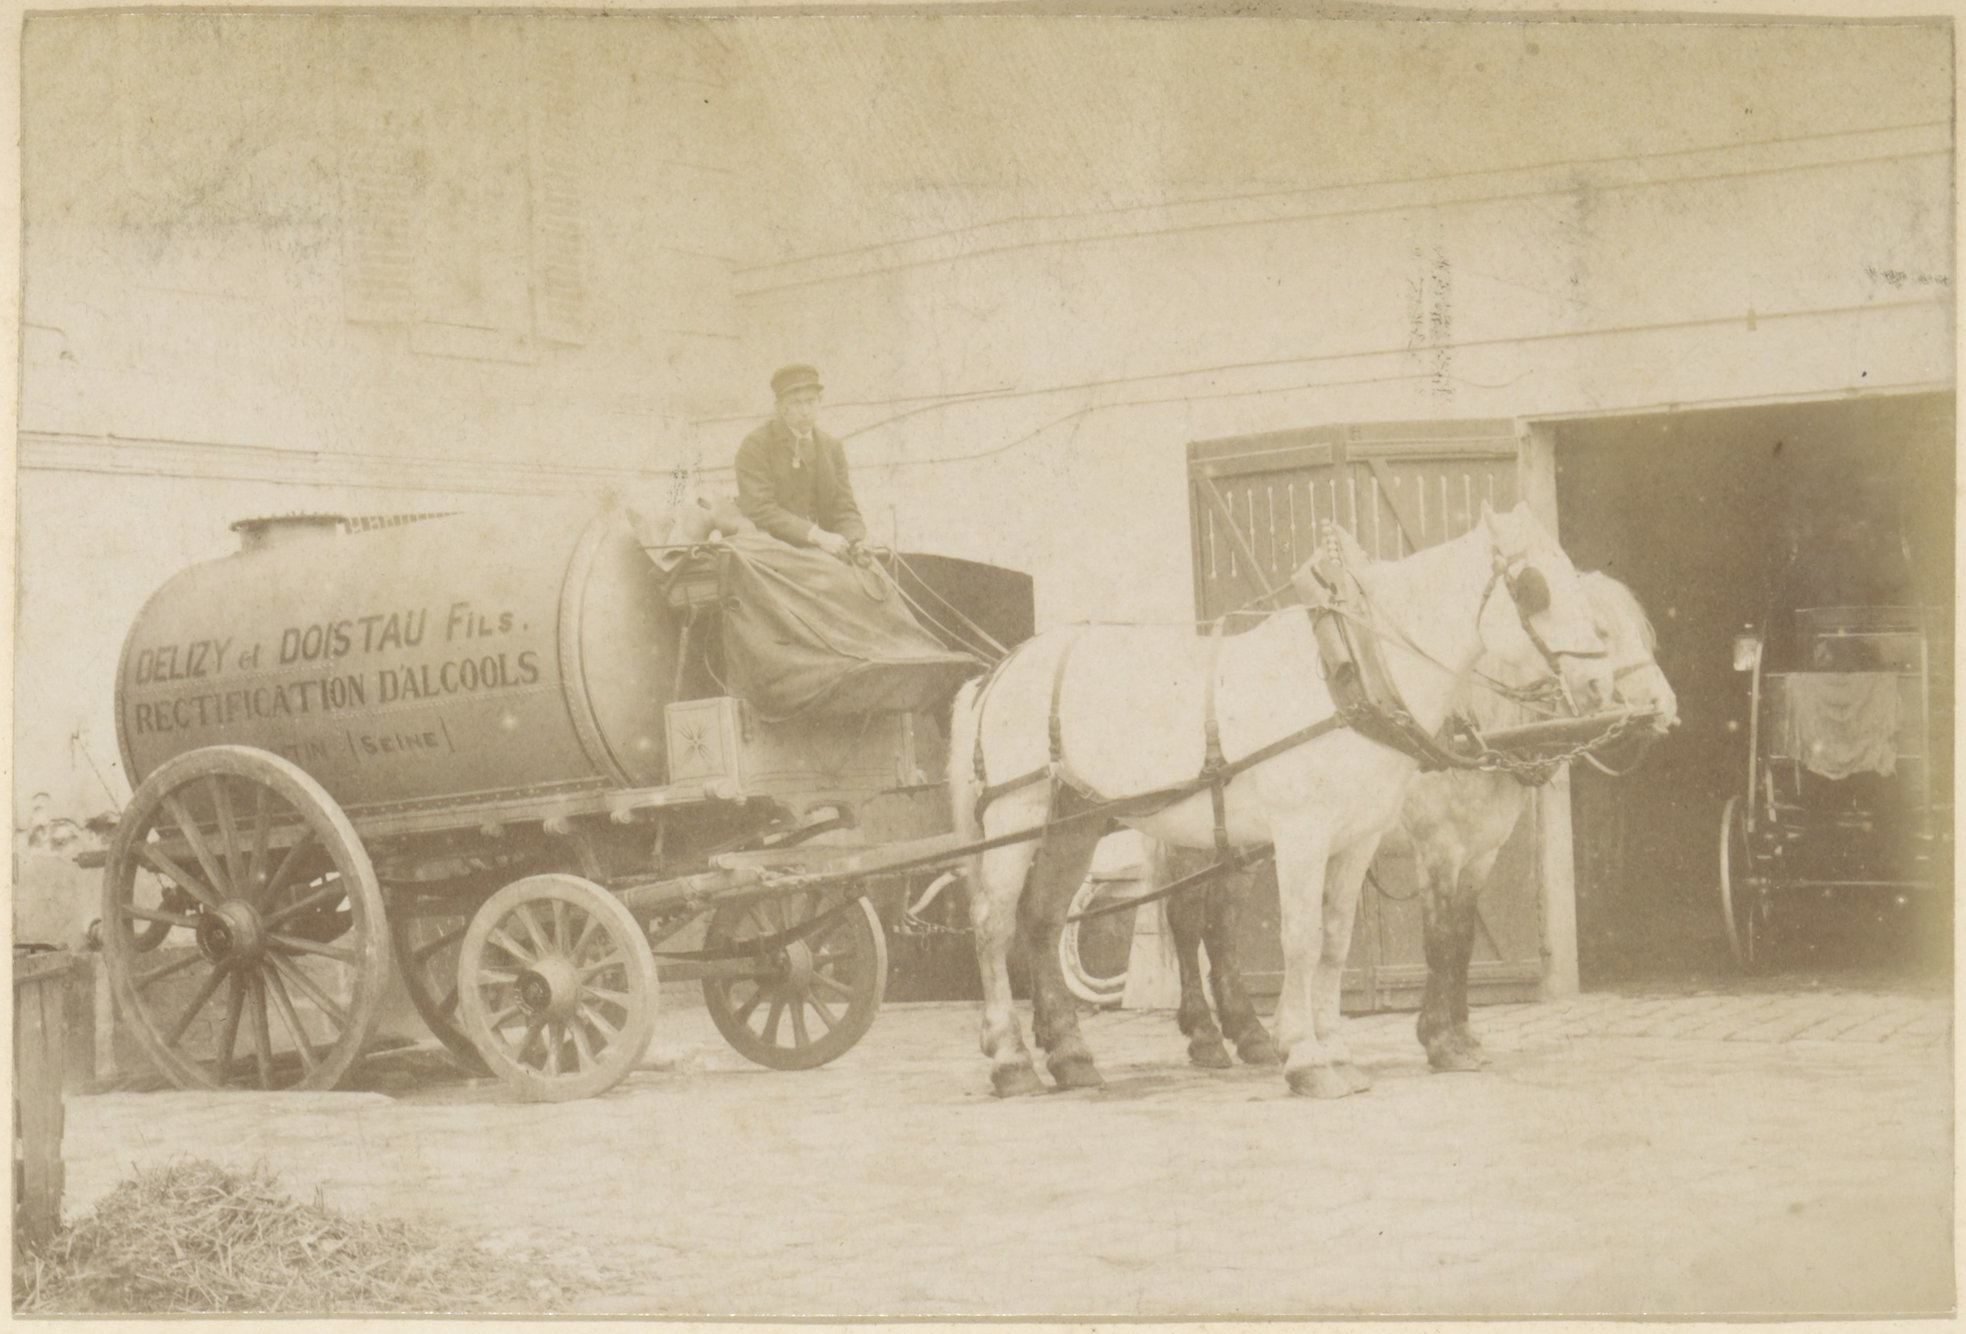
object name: photograph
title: Paardenkar met alcoholtank van de firma Delizy & Doistau Fils (Rectification d'Alcools) in Pantin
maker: Anonymous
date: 1900-1910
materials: paper, photographic support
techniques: albumen print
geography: france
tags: four-wheeled, animal-drawn vehicle, e.g.: cab, carriage, coach, container of metal: bucket, can, canister, drum, tin, france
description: Onderdeel van Fotoalbum van een Franse amateurfotograaf met opnames van een familie, distilleerderij Delizy & Doistau Fils, het leger en bezienswaardigheden in Frankrijk.